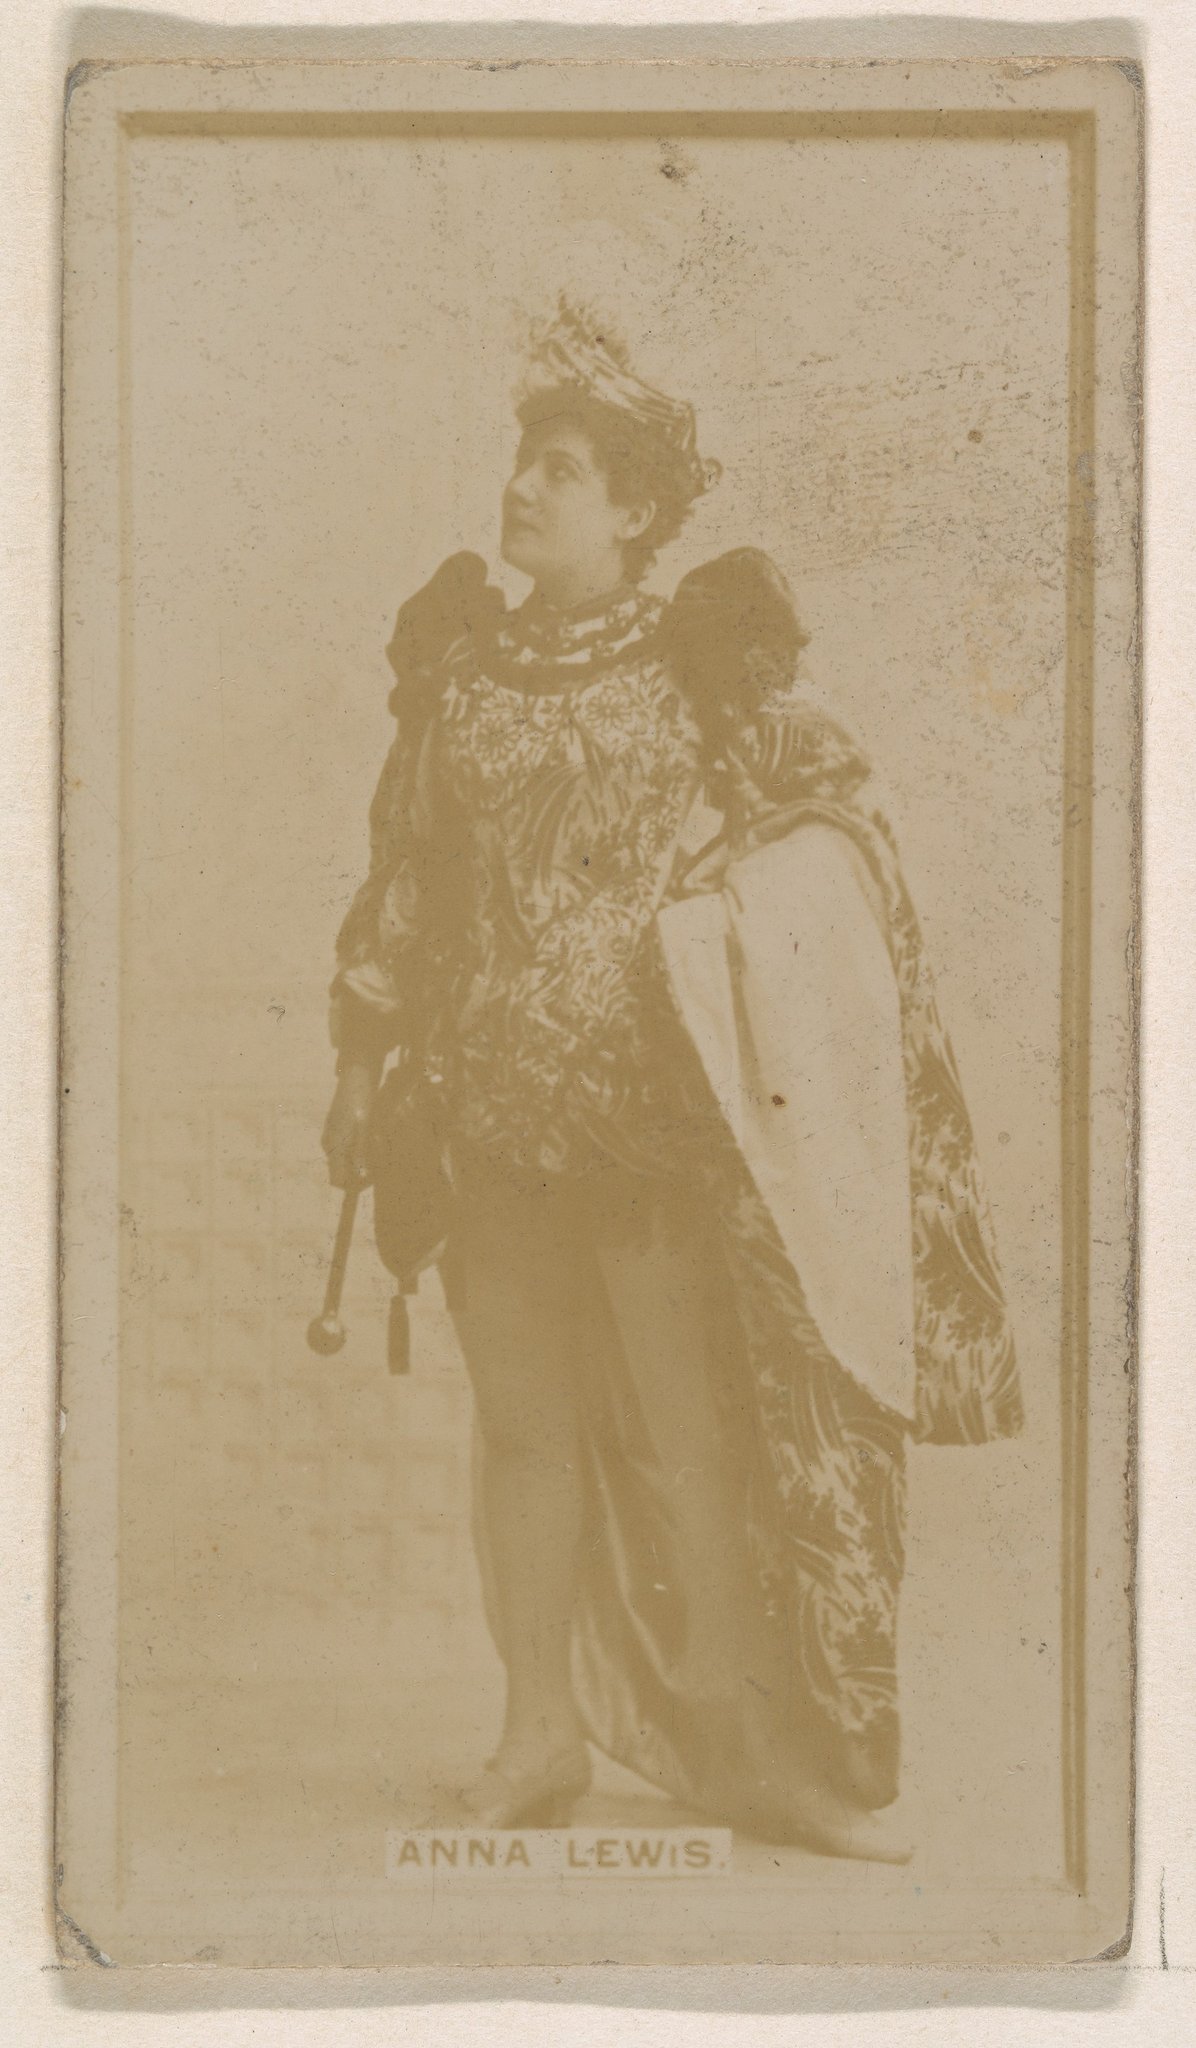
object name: photograph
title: Anna Lewis, from the Actresses series (N245) issued by Kinney Brothers to promote Sweet Caporal Cigarettes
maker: kinney brothers tobacco company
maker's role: publisher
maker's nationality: american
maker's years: 1869-2011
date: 1890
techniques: albumen silver print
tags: women,actresses